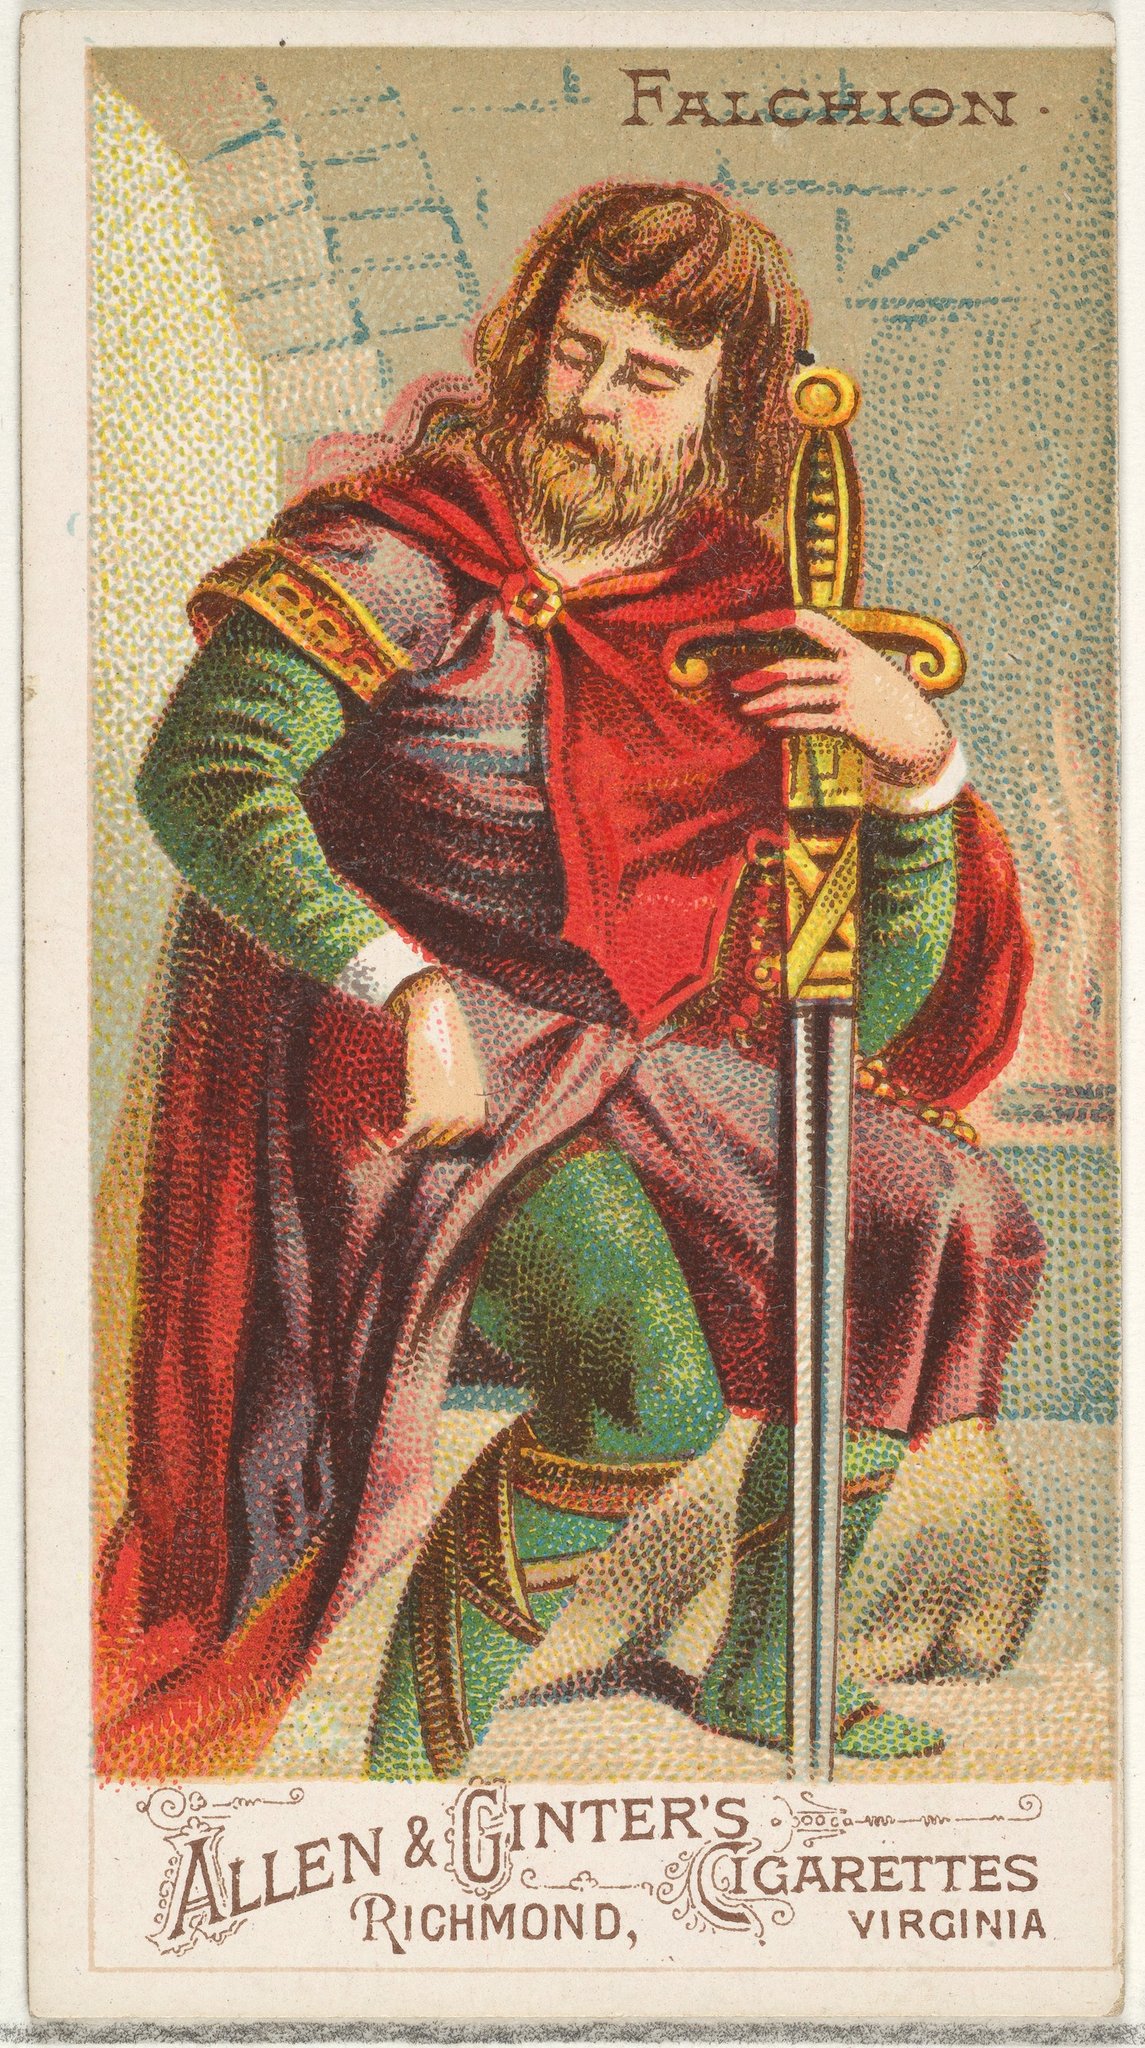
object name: print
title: Falchion, from the Arms of All Nations series (N3) for Allen & Ginter Cigarettes Brands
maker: allen & ginter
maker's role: publisher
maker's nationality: american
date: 1887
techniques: color lithograph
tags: swords,men